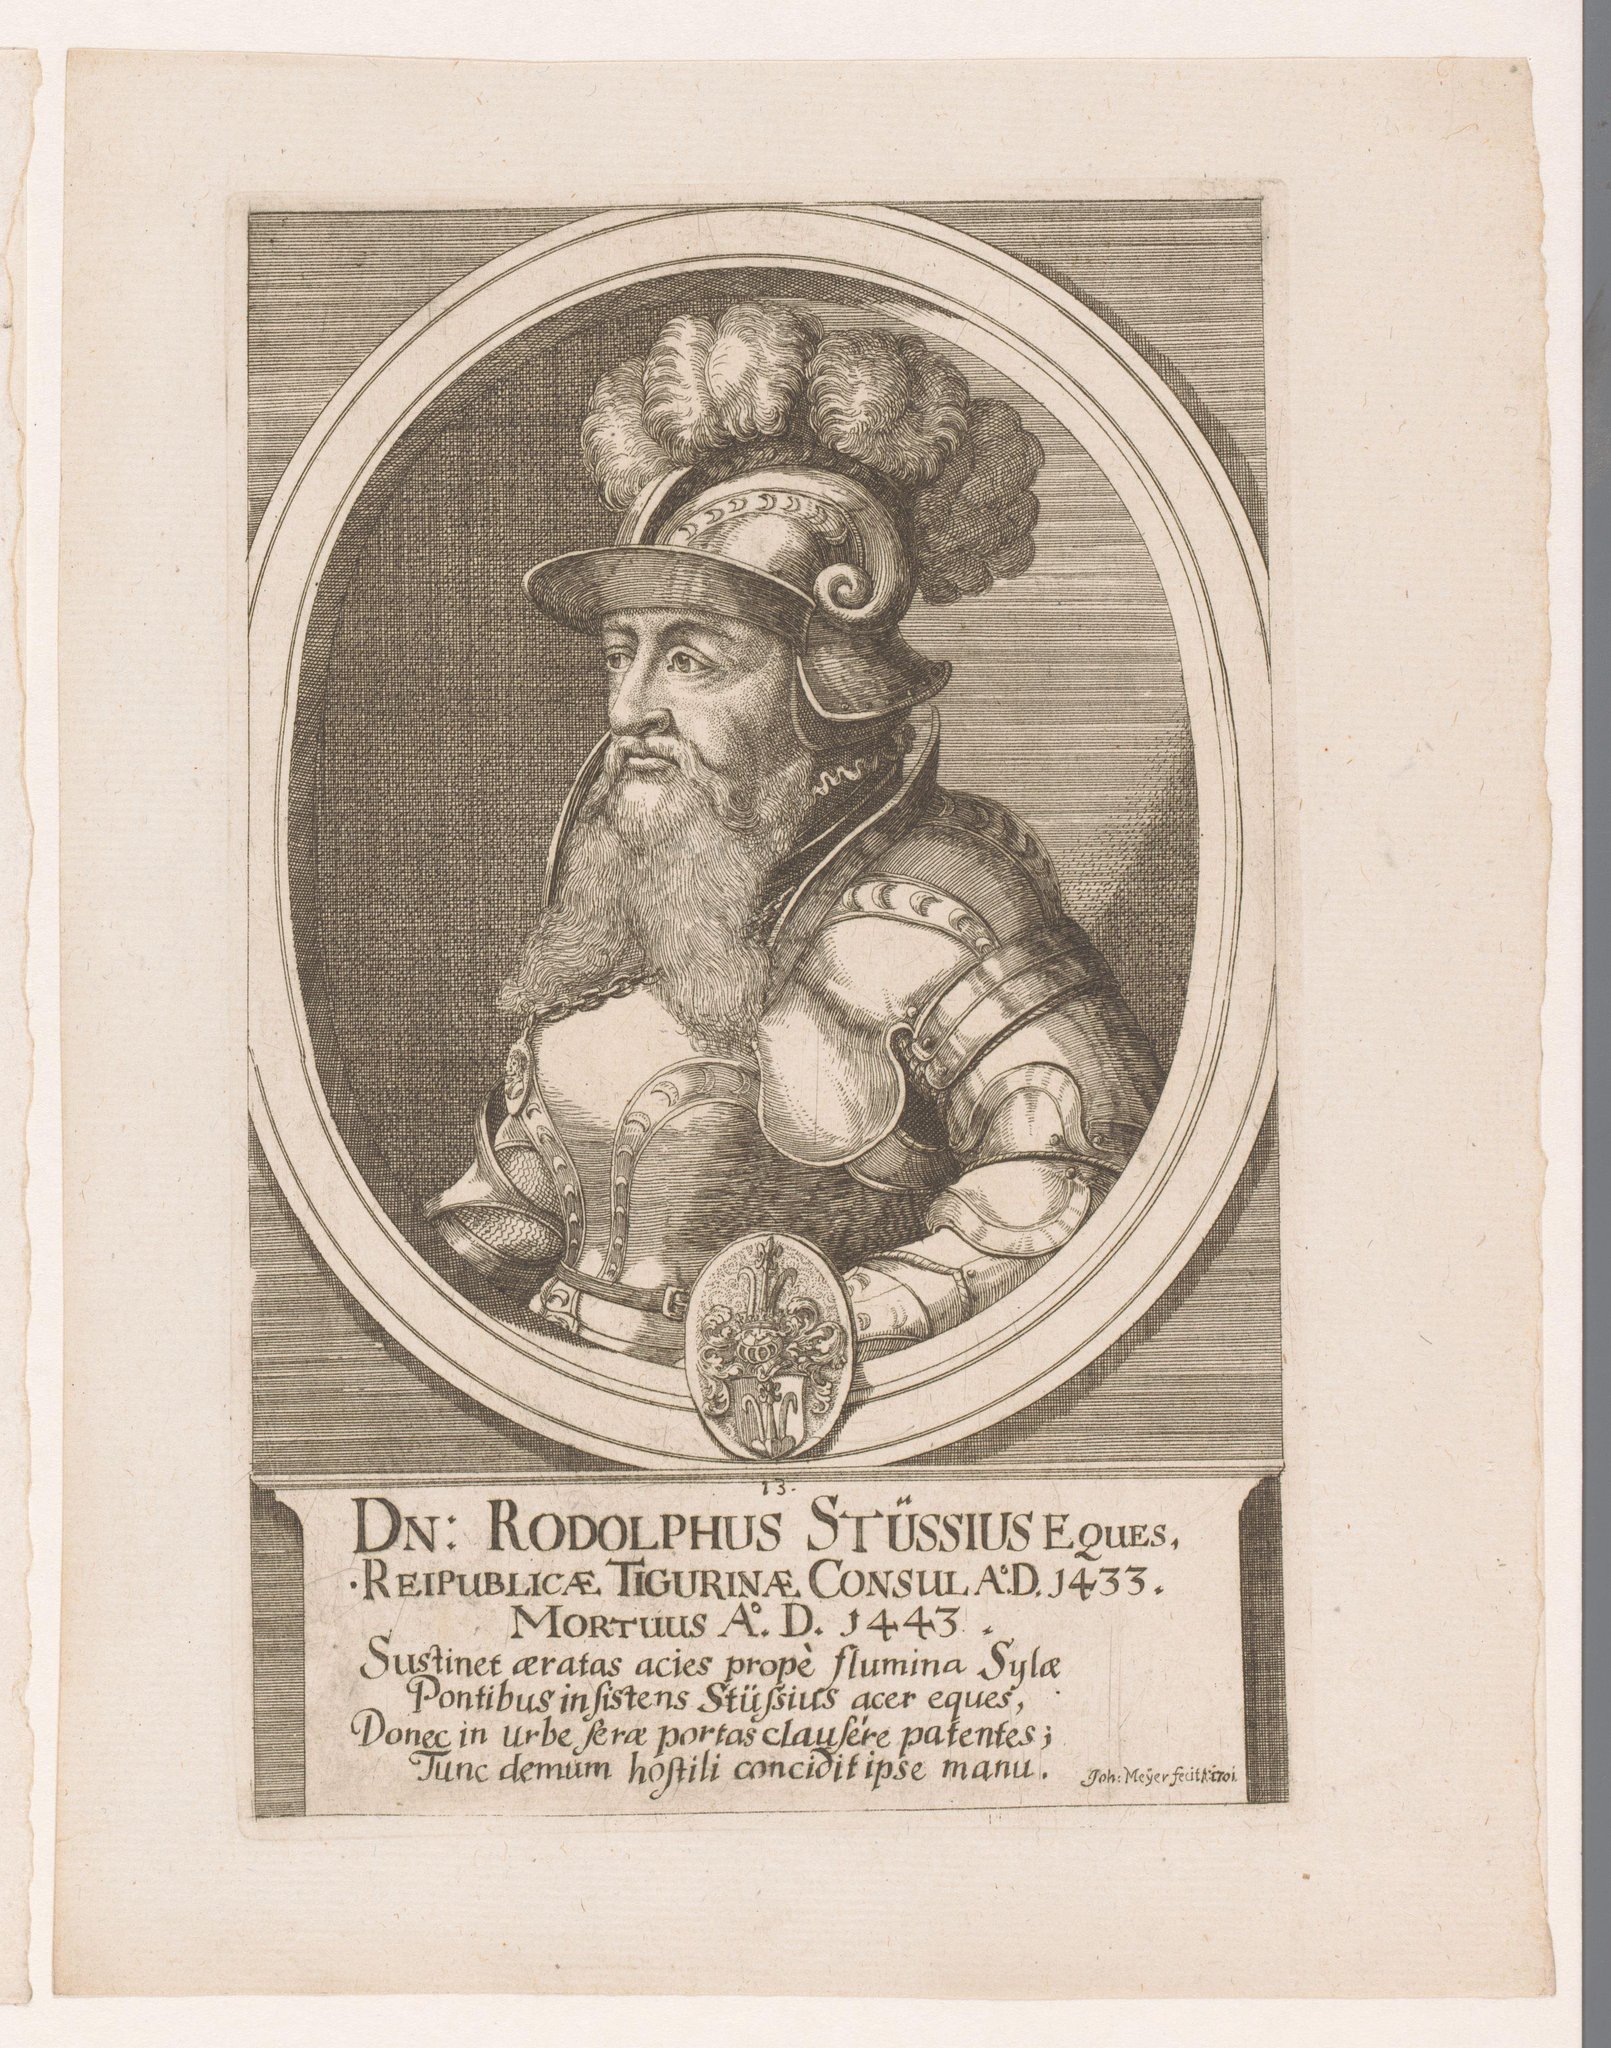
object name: print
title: Portretten van burgemeesters van Zürich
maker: johannes meyer (ii)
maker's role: print maker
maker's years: 1655-1712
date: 1701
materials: paper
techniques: engraving, etching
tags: mayor, mayor, burgomaster, armour, historical persons, armorial bearing, heraldry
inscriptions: collector's mark: Lugt 2228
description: Onderaan de ovale omlijsting genummerd: 13.